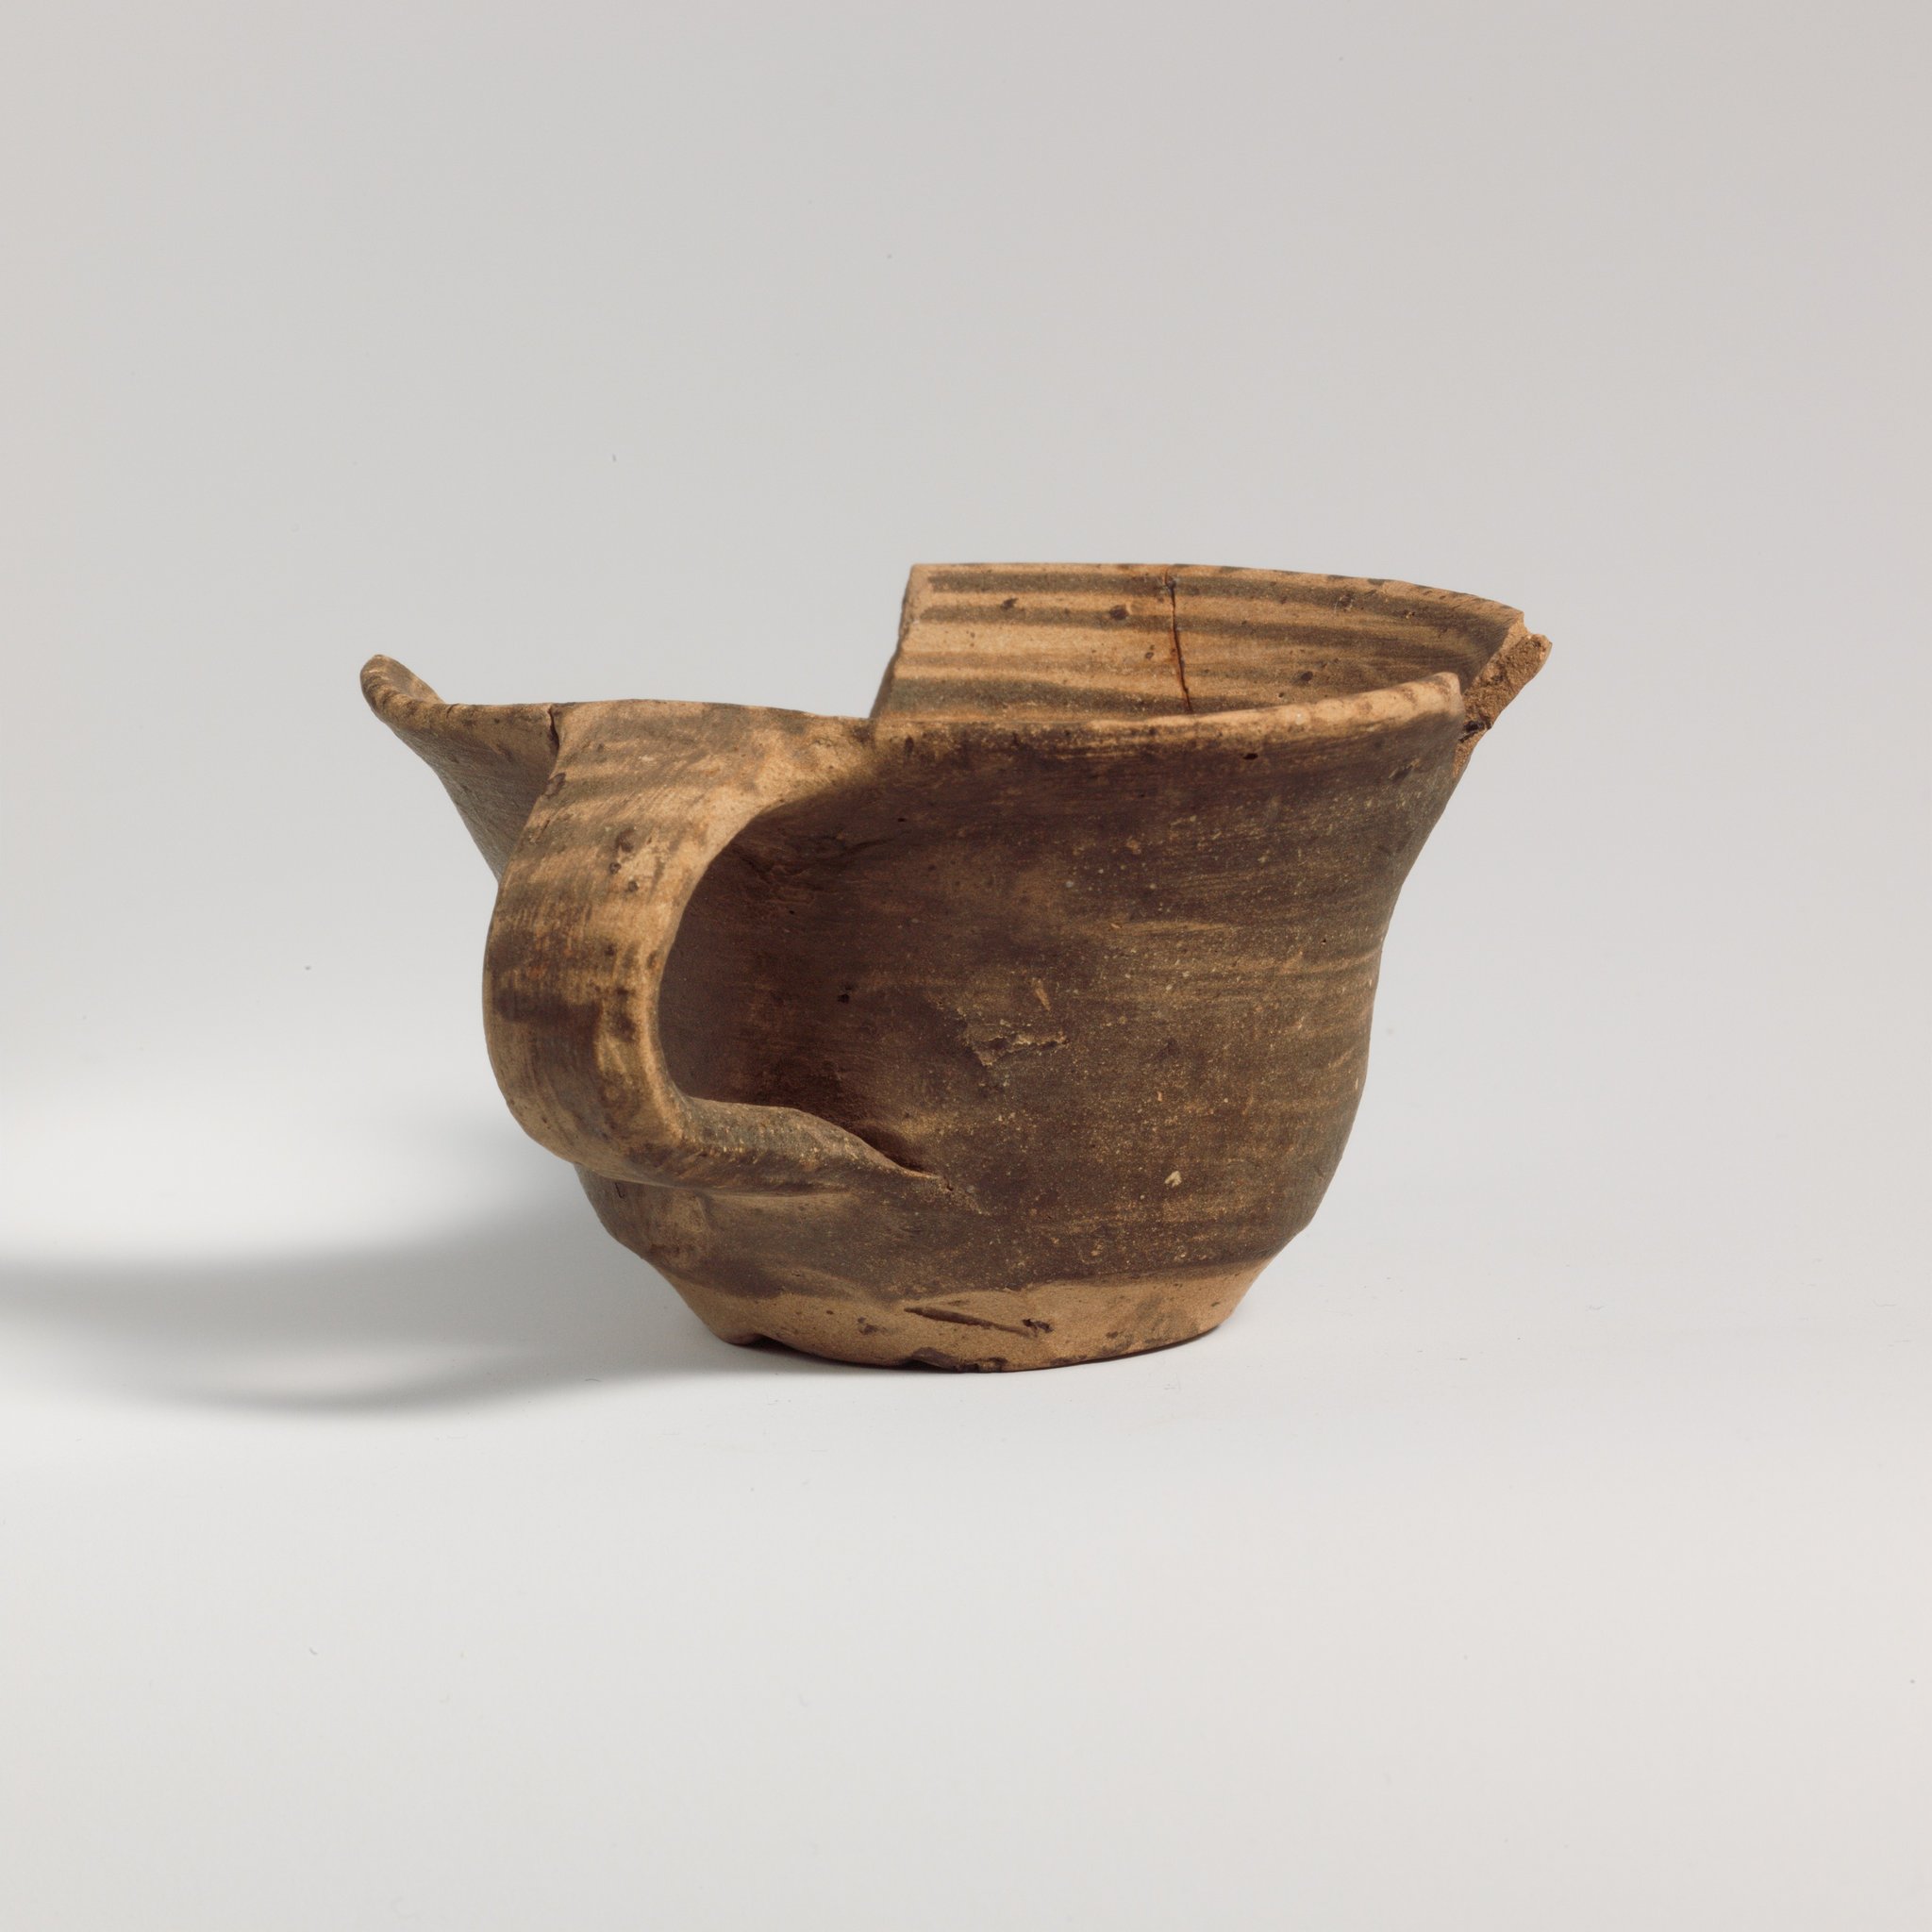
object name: cup, one handled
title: Terracotta cup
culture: greek, attic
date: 700-668 BCE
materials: terracotta